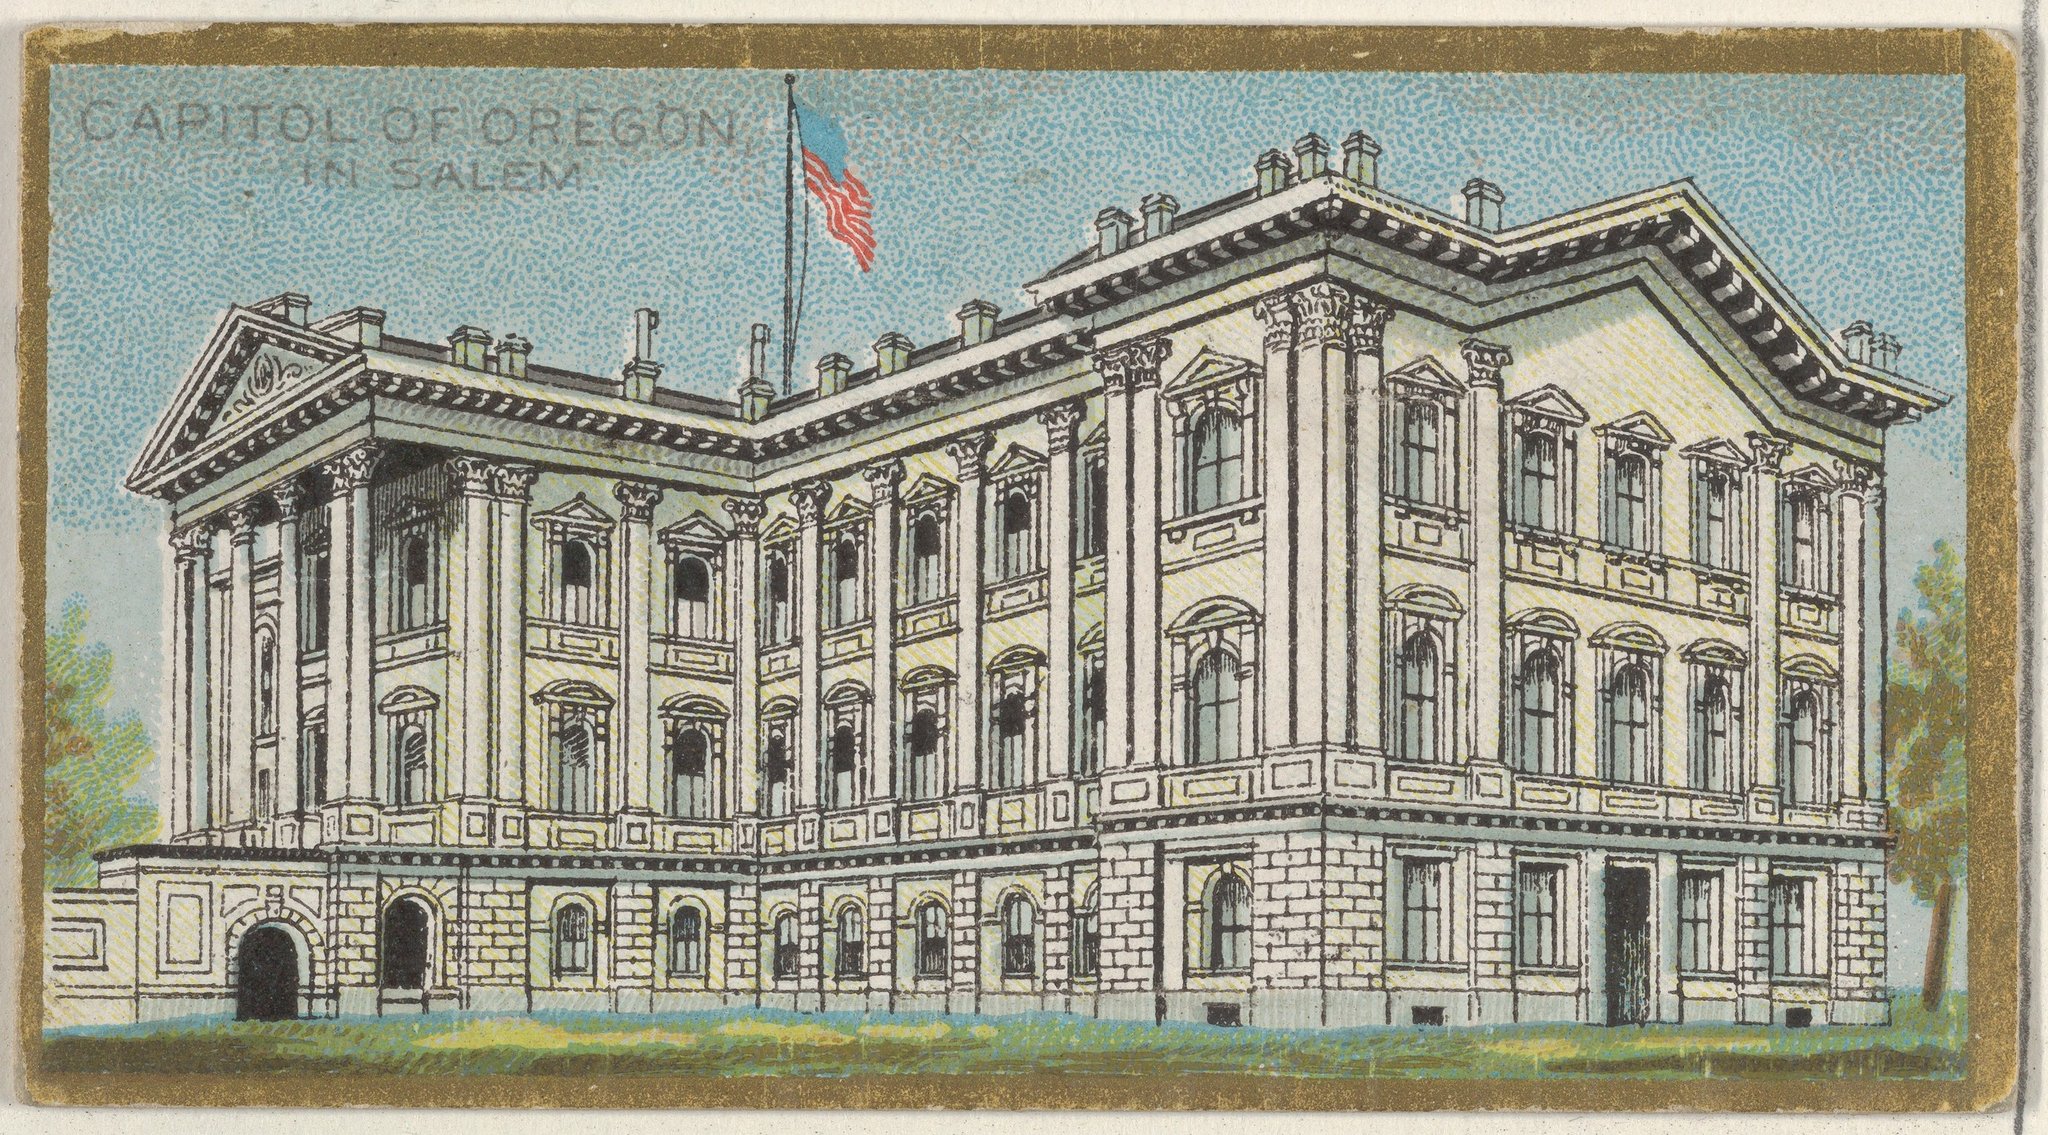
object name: print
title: Capitol of Oregon in Salem, from the General Government and State Capitol Buildings series (N14) for Allen & Ginter Cigarettes Brands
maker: allen & ginter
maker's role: publisher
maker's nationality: american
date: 1889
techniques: color lithograph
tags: buildings